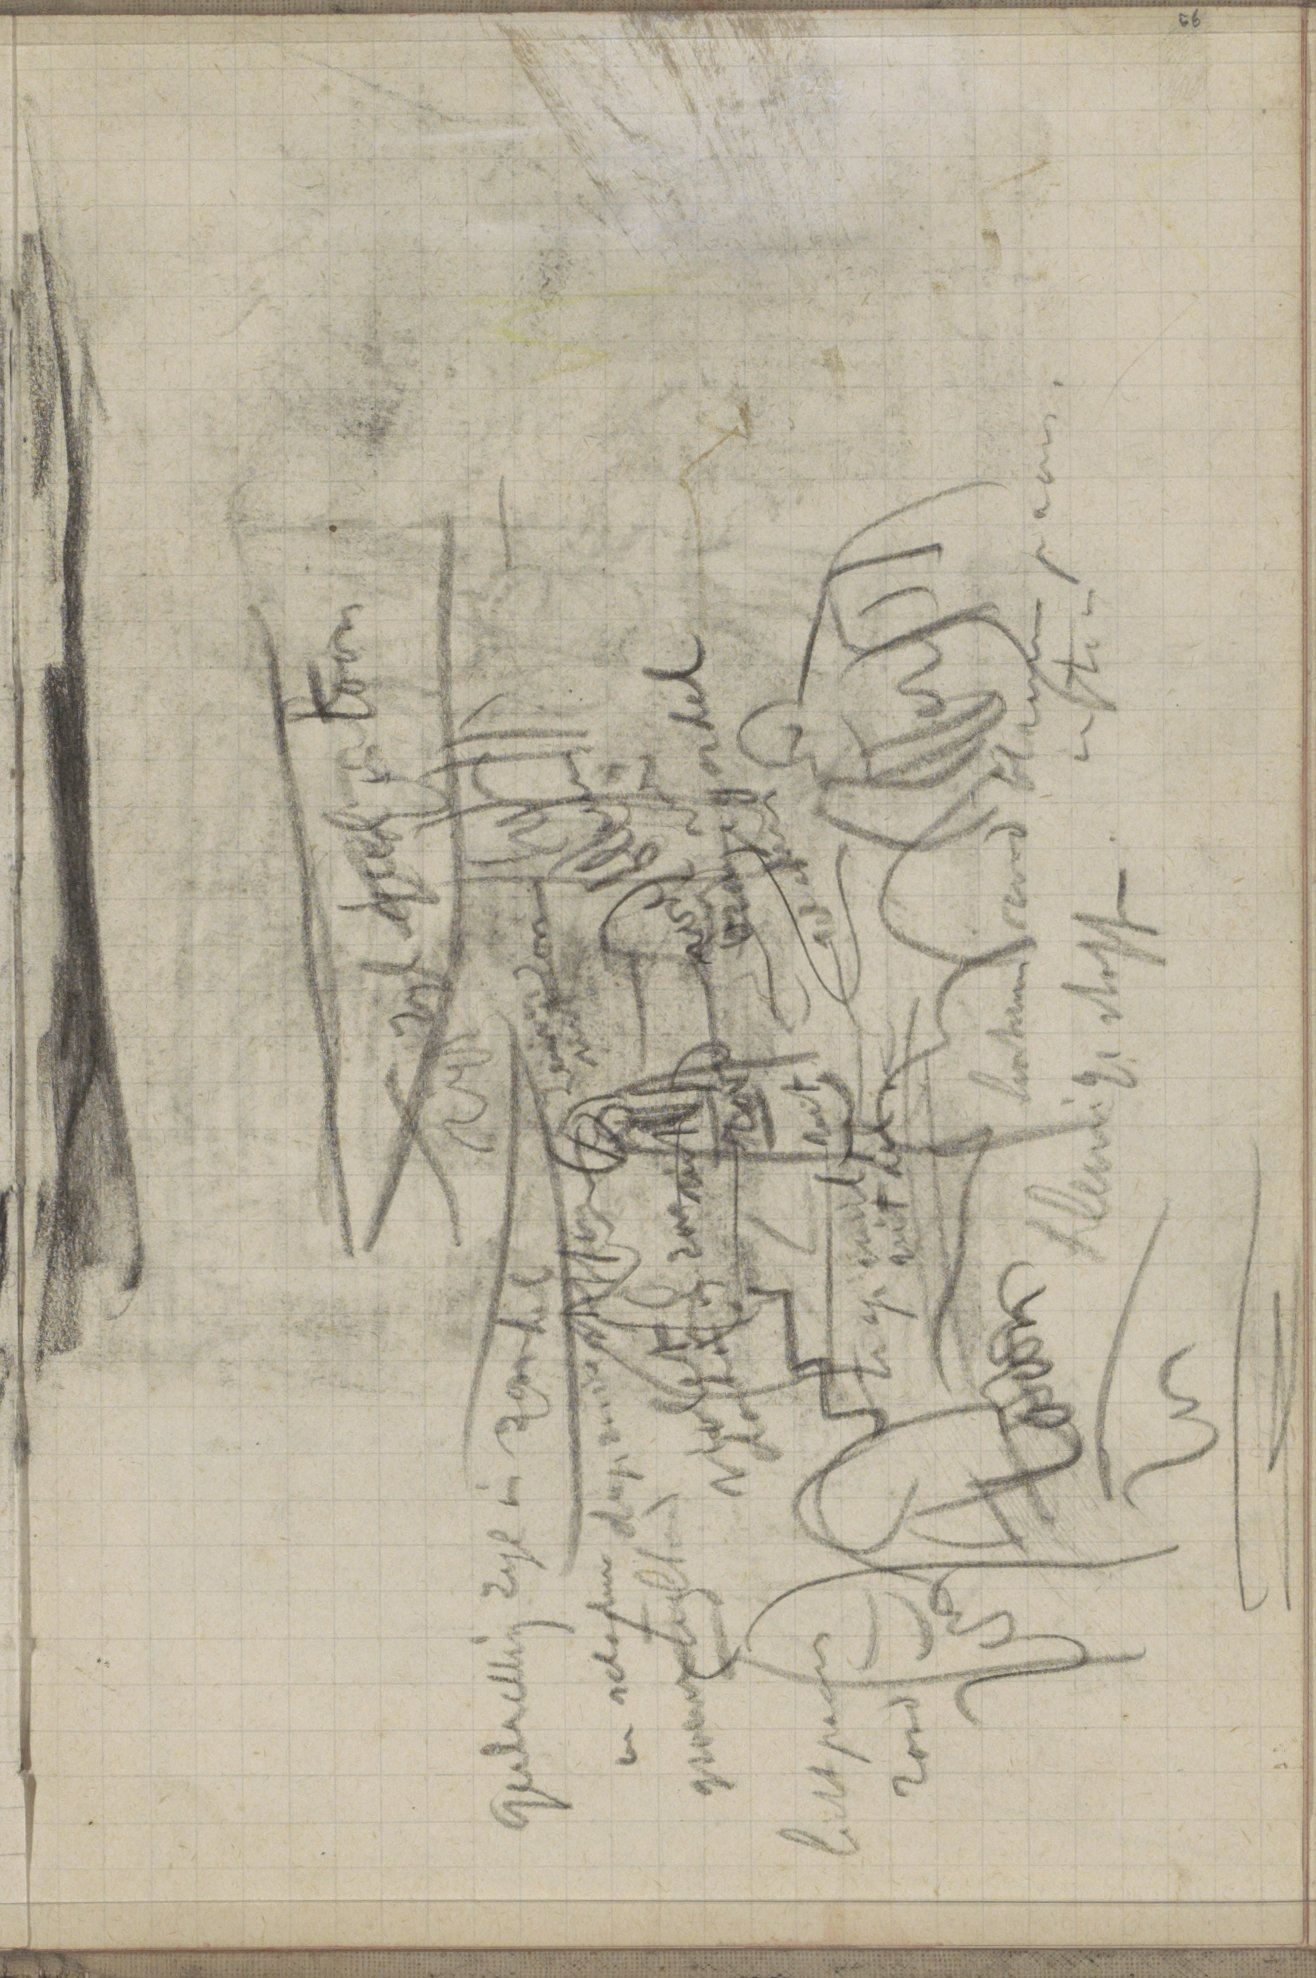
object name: sketchbook leaf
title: Figuren op een trap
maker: marius bauer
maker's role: draughtsman, print maker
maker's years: 1867-1932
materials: chalk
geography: istanbul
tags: asiatic races and peoples, sloping street; street with steps or stairs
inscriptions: kleurnotitie, handgeschreven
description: Vermoedelijk in een straat. Pagina 56 uit een schetsboek met 54 bladen.